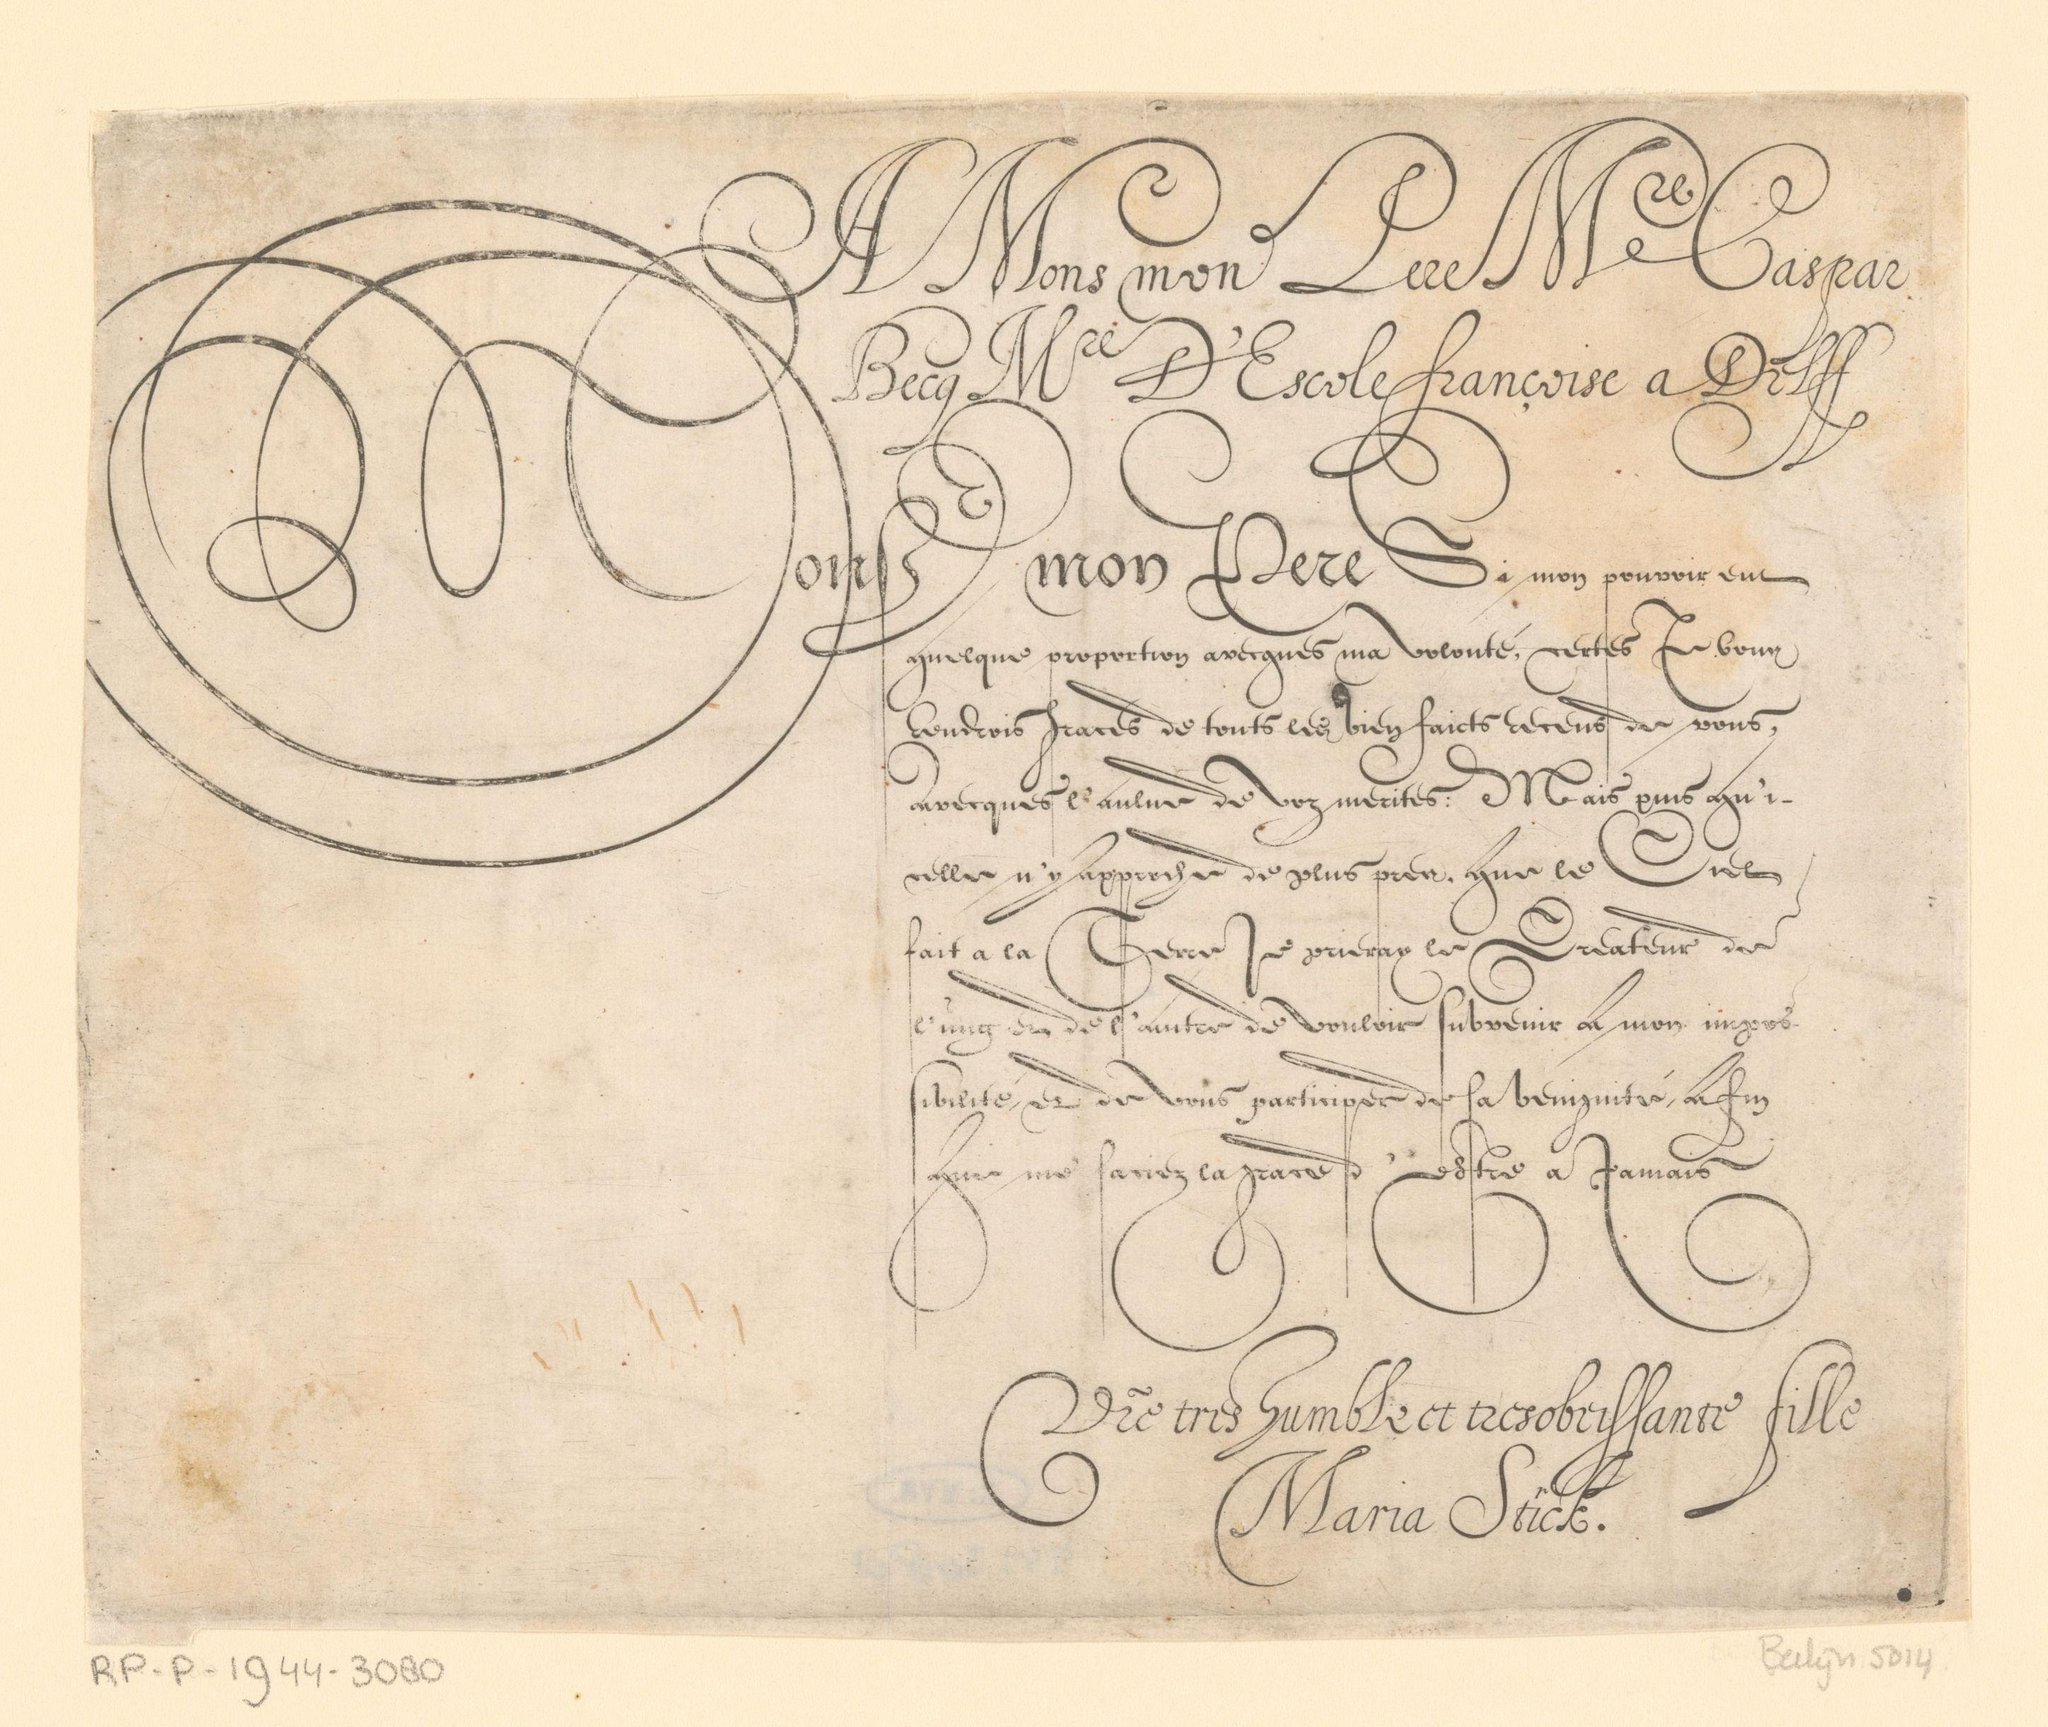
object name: ornament print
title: Tooneel Der loflijcke Schrijfpen (...)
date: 1617-1618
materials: paper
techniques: engraving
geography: delft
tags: calligraphy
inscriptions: collector's mark: Lugt 2228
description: Gekalligrafeerde tekst: A Mons mon Pere Mr Caspar (...)